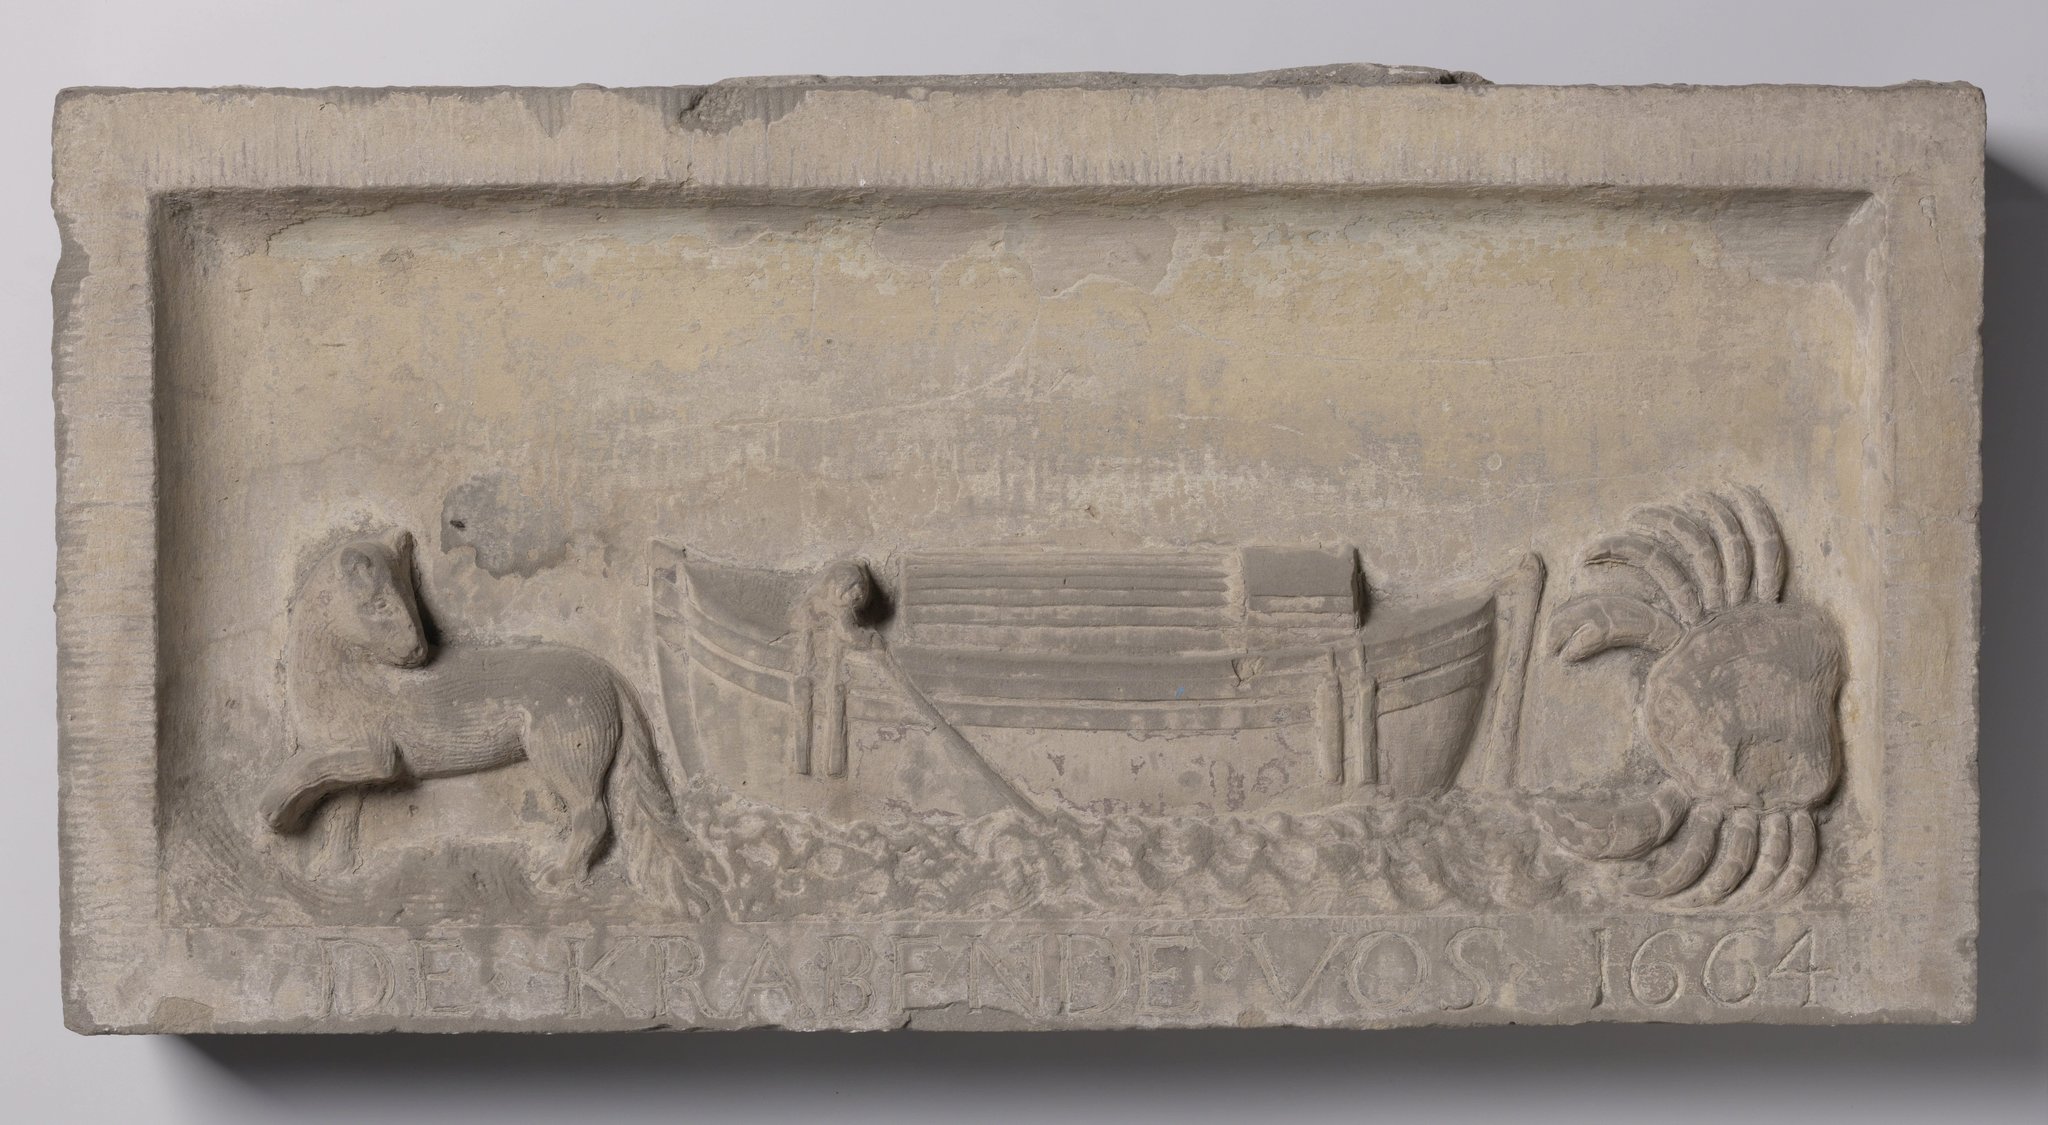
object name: gable stone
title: Gevelsteen met een bomende schuitenvoerder, voor hem uit een vos, achter de schuit een krab; daaronder de tekst DE KRAB EN DE VOS 1664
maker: Anonymous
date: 1664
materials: stone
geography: netherlands